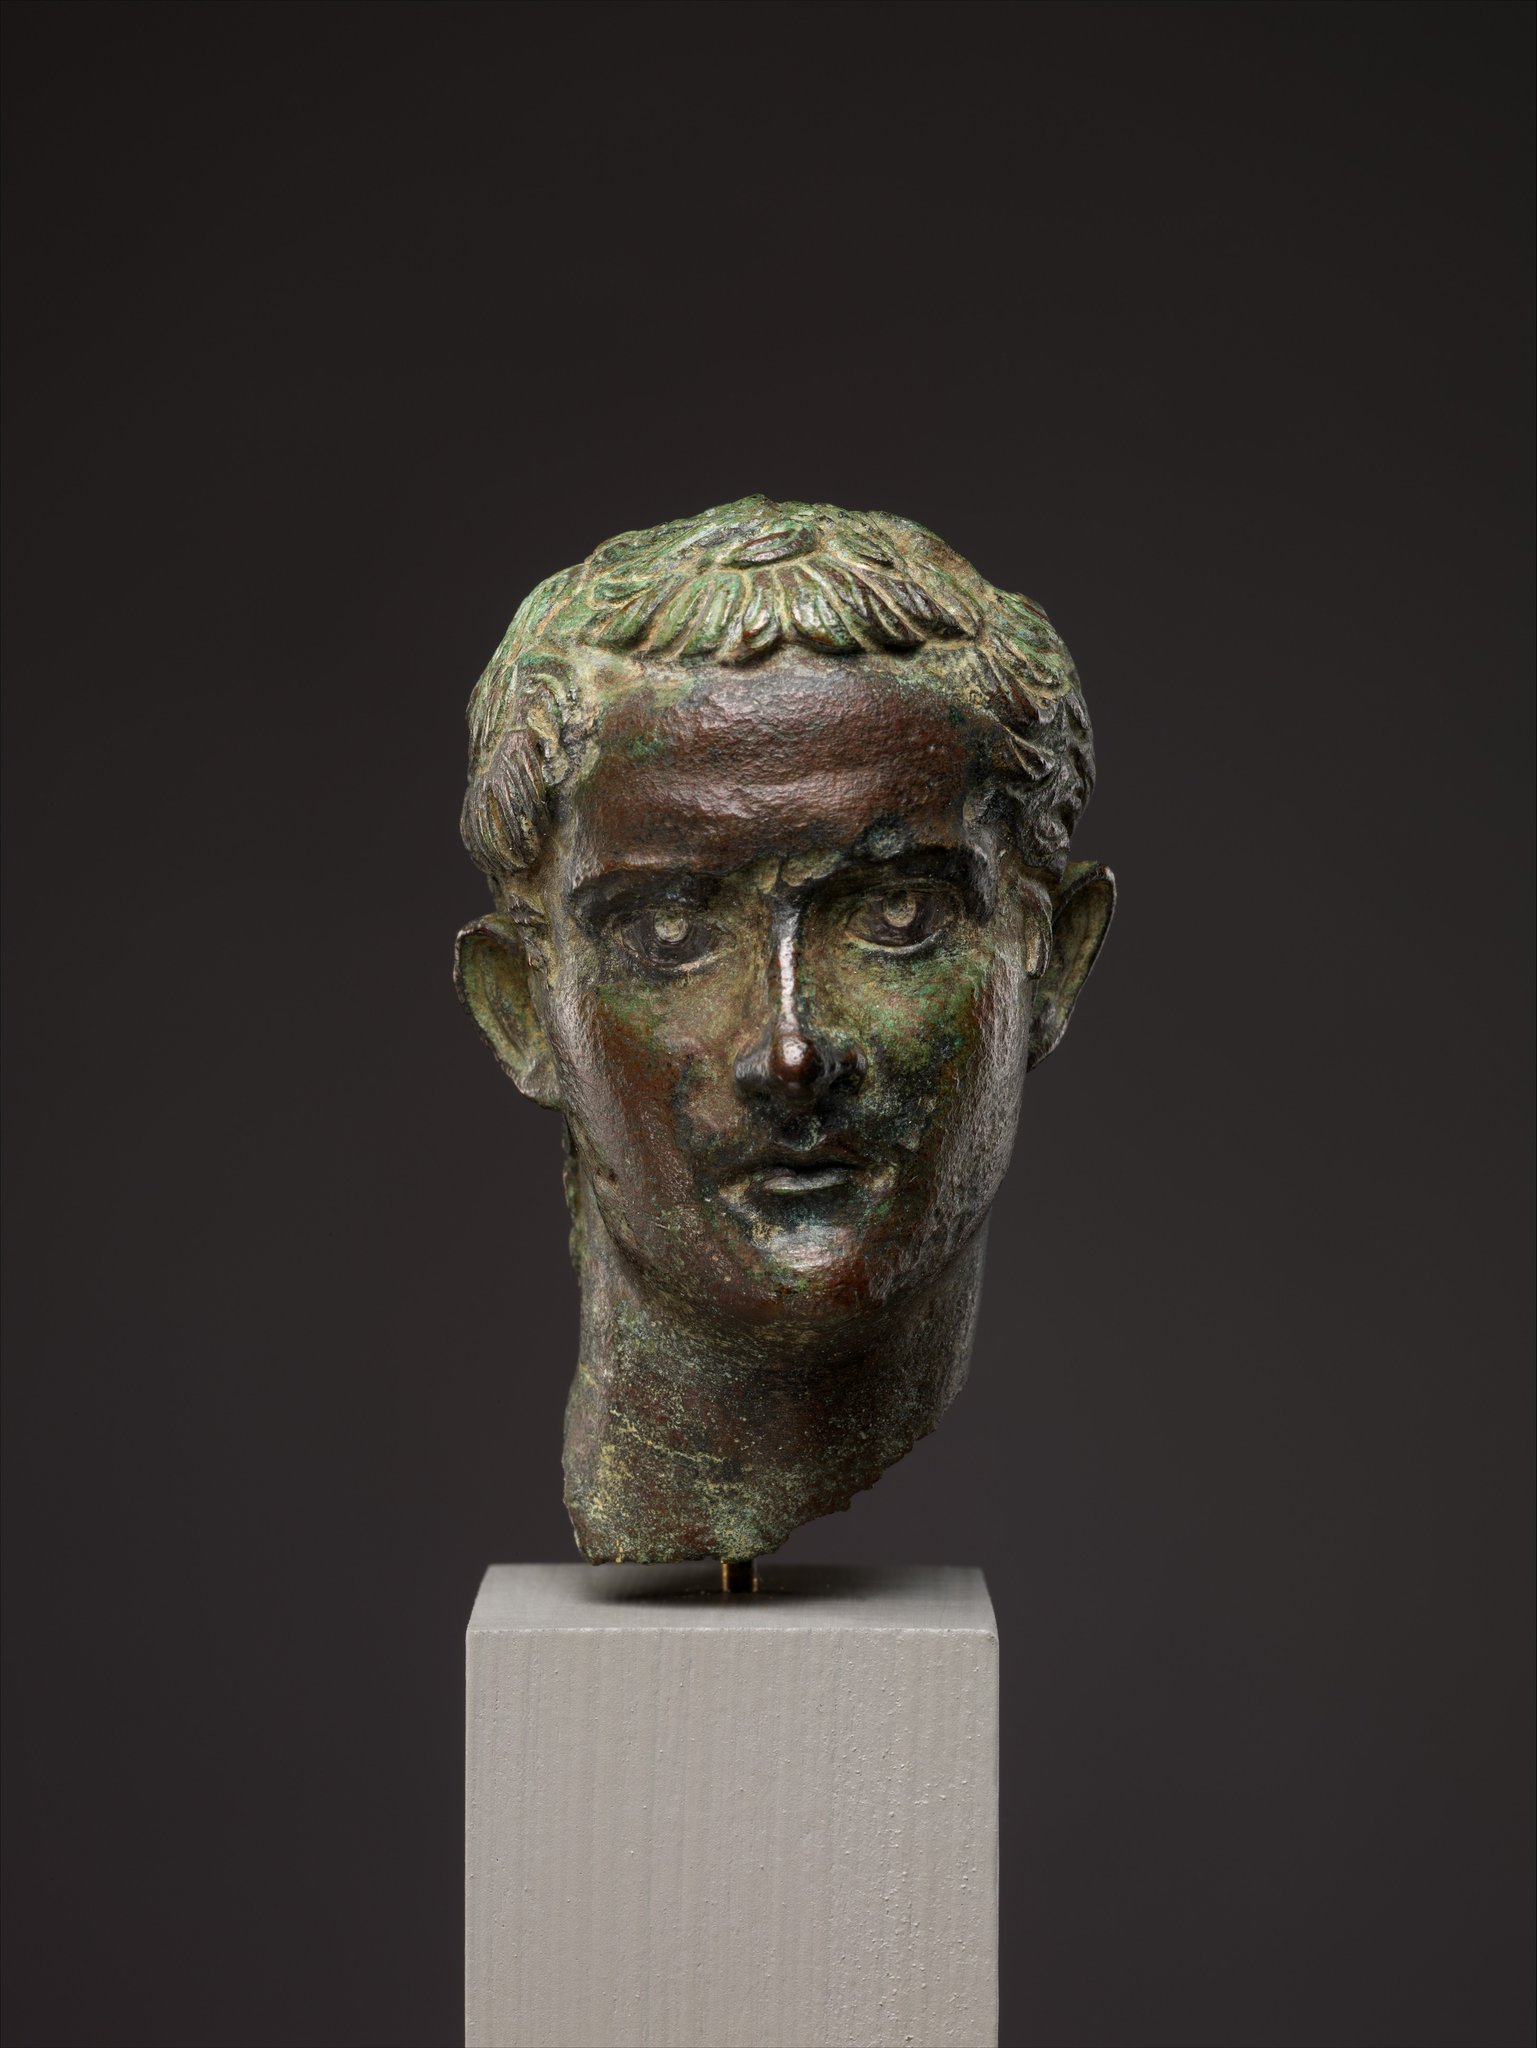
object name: portrait head of the emperor caligula gaius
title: Bronze portrait head of the emperor Gaius (Caligula)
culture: roman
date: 37-41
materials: bronze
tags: heads,men,portraits